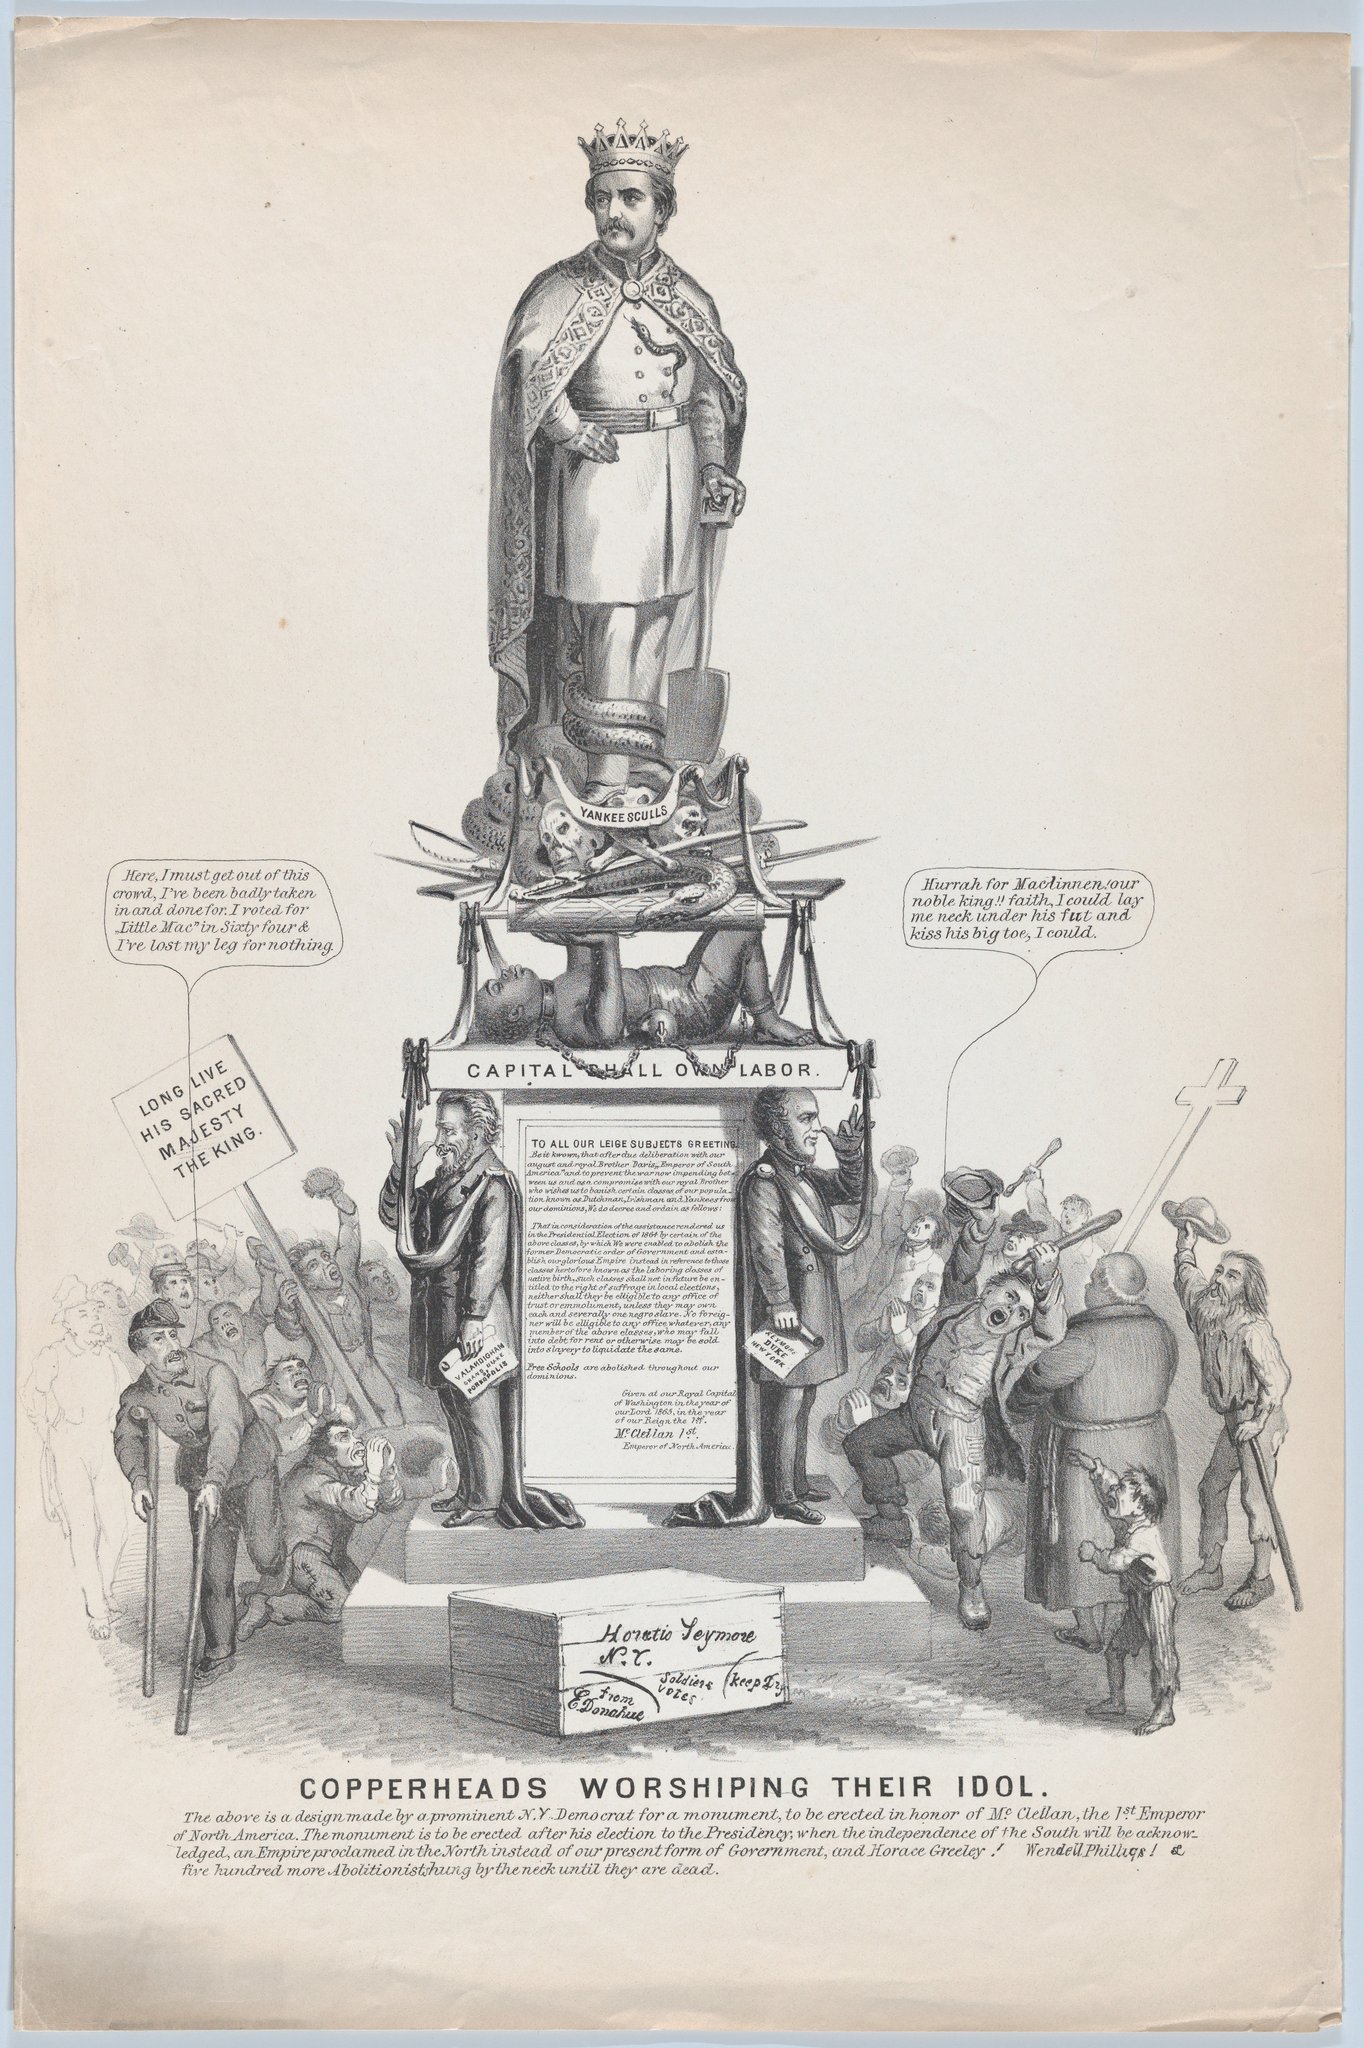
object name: print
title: Copperheads Worshiping Their Idol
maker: anonymous, american, 19th century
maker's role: artist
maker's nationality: american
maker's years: 1800-1900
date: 1864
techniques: lithograph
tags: satire,skulls,men,politics,slaves